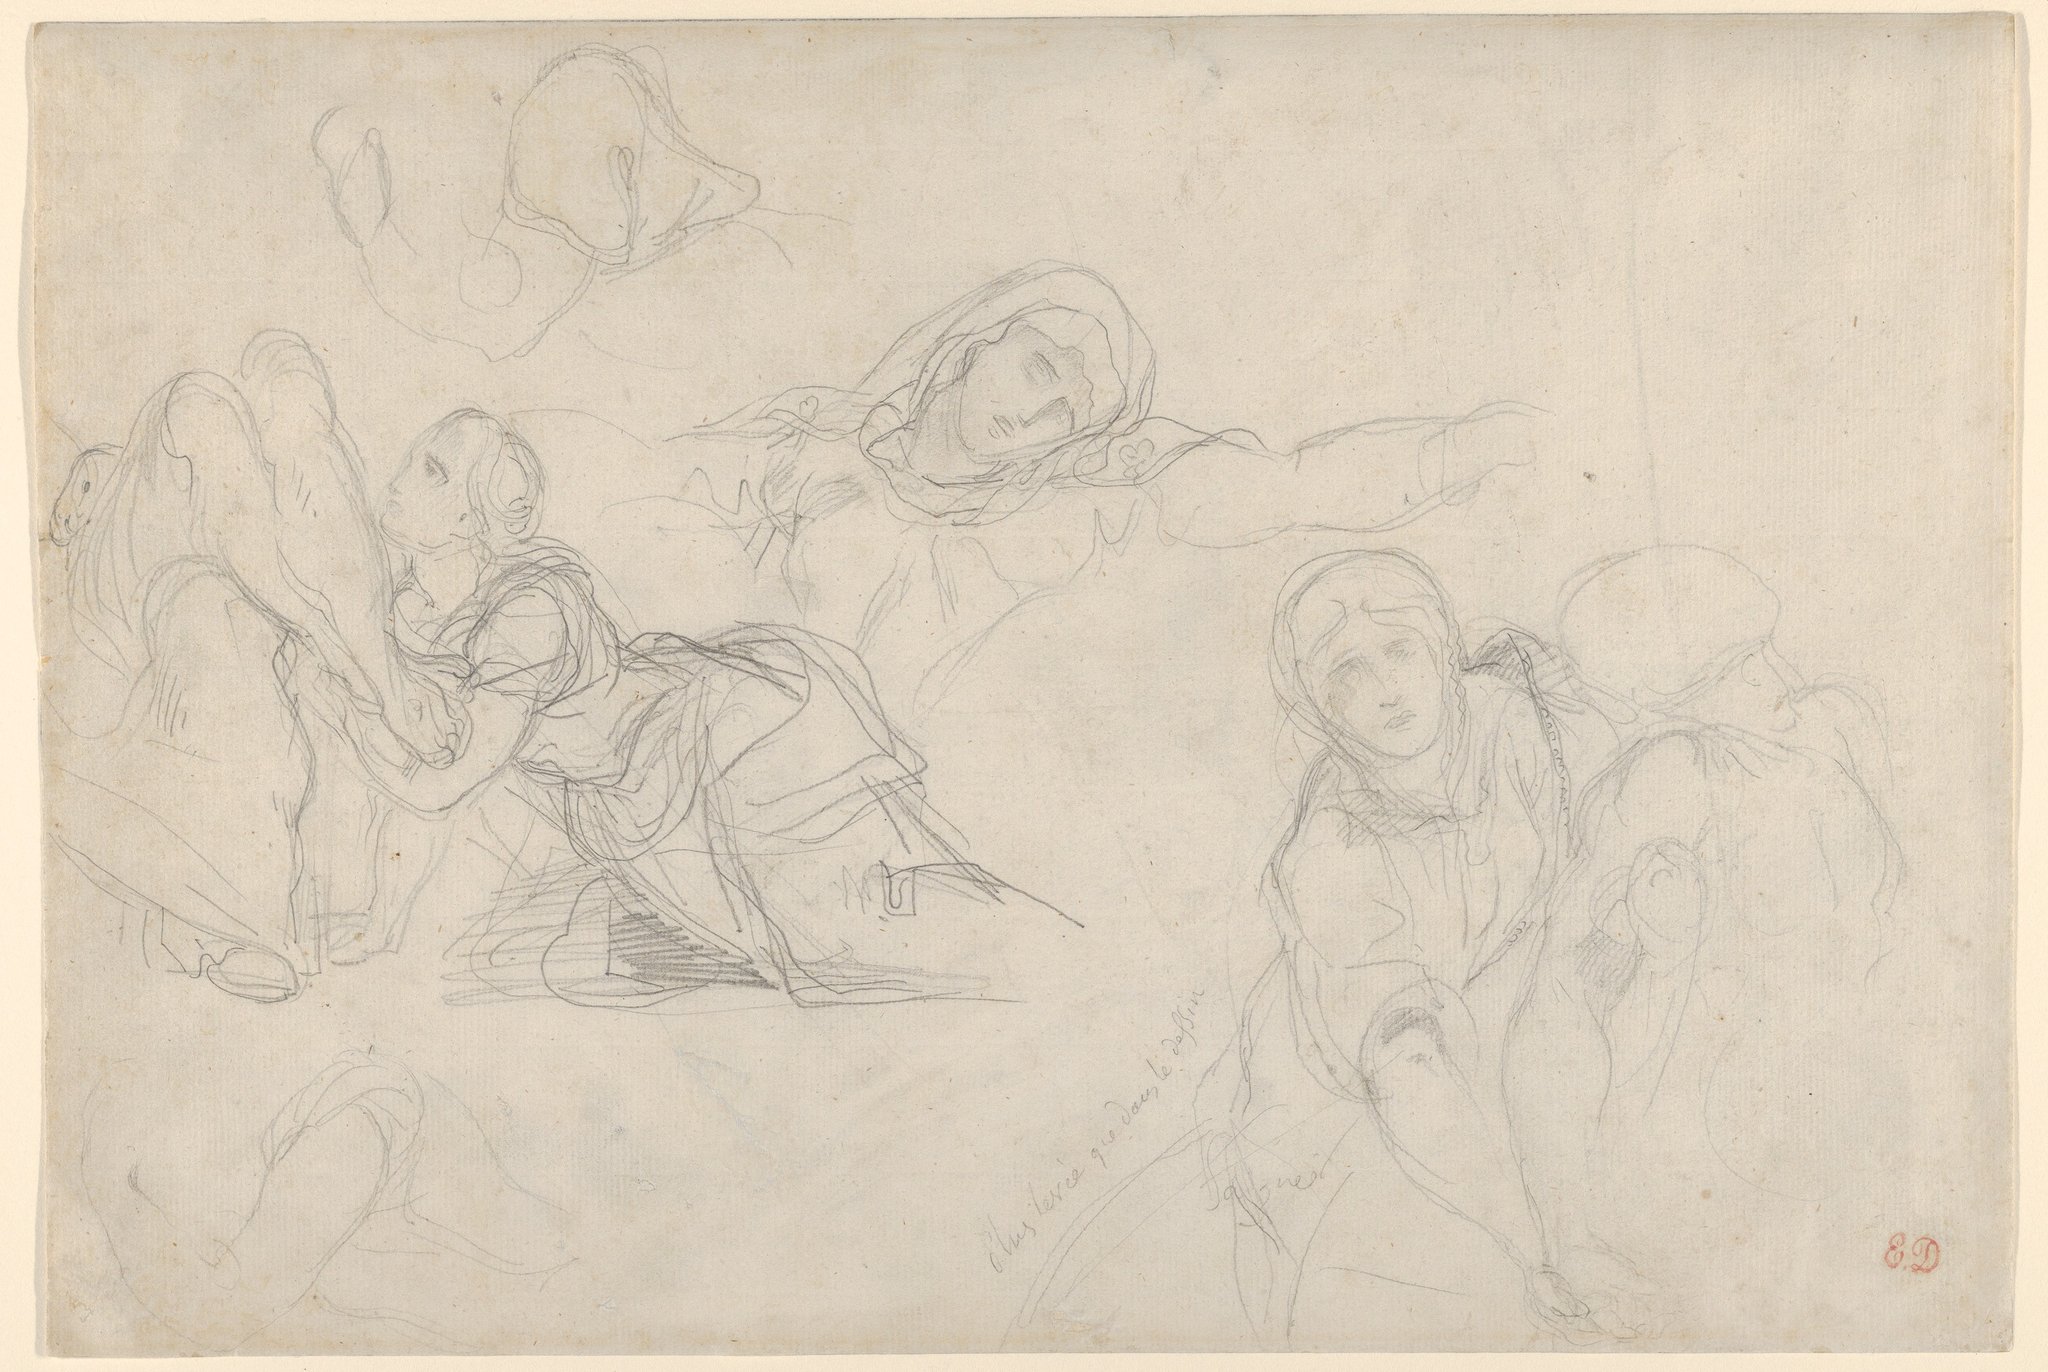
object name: drawing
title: Studies of the Virgin and Holy Women for "The Lamentation"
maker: eugène delacroix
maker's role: artist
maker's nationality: french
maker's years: 1798-1863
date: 1842-1843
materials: graphite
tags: women,virgin mary,lamentation